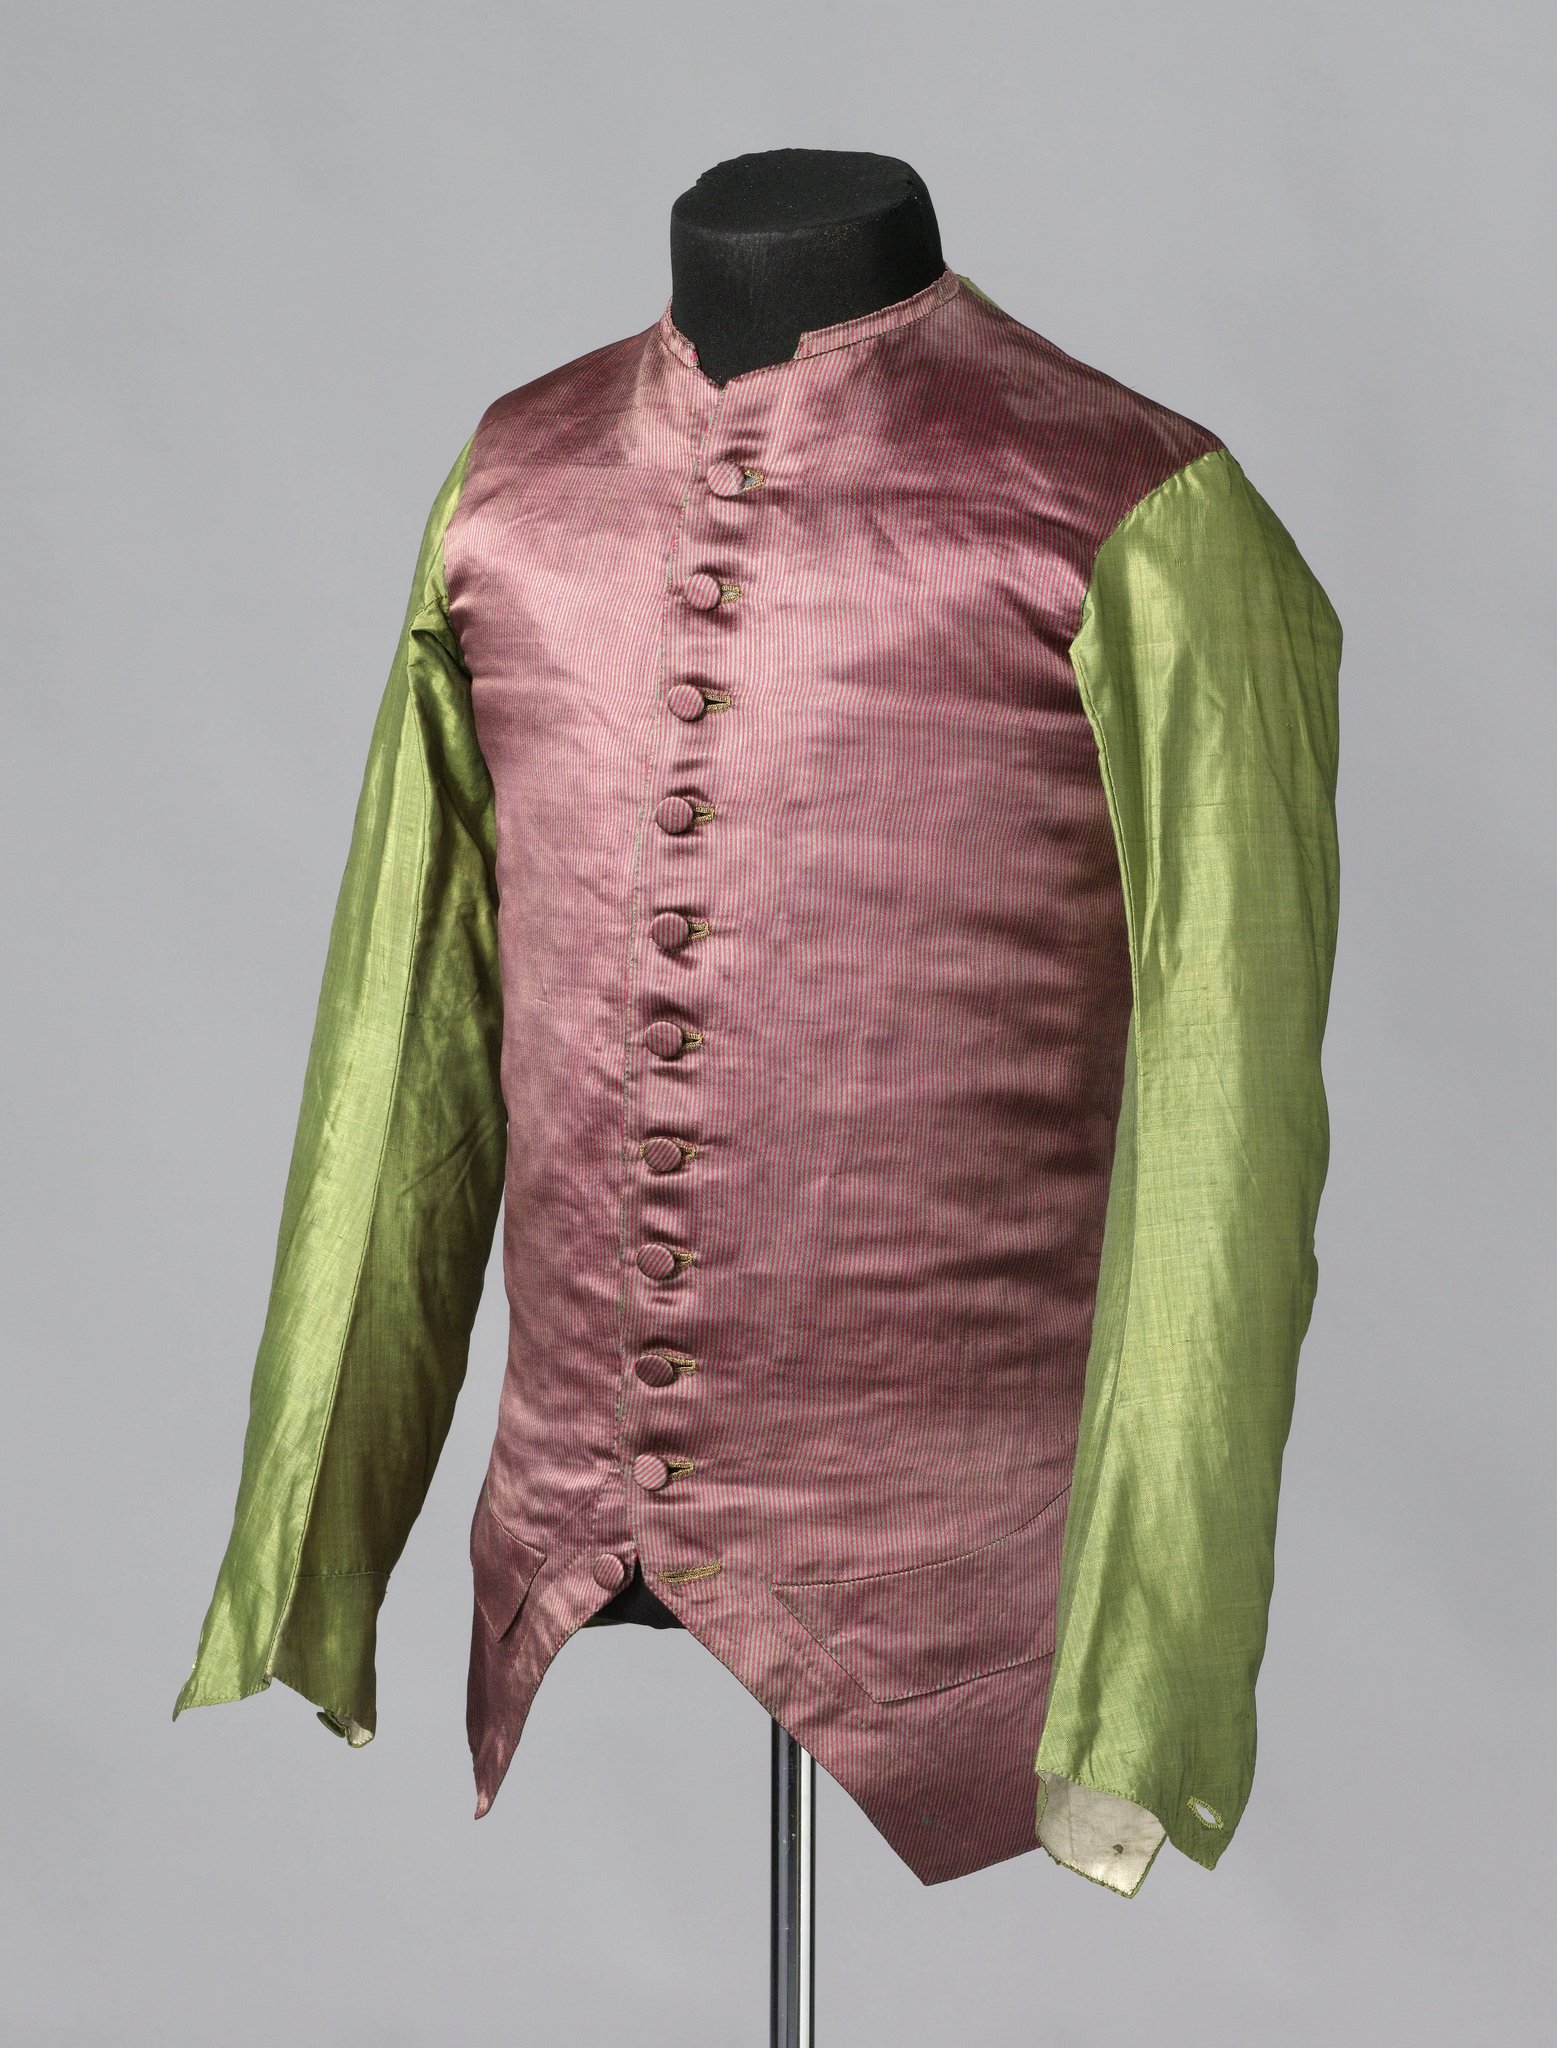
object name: cardigan waistcoat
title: Hooggesloten mouwvest met twee lage zakken met klep en 11 stofknopen, fijn roodgroen gestreept satijn; mouwen en deel van de rug van groene zijde, voering linnen en katoen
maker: Anonymous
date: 1760-1770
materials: cotton, textile, linen, silk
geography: netherlands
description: Hooggesloten mouwvest met twee lage zakken met klep en 11 stofknopen, fijn roodgroen gestreept satijn; mouwen en deel van de rug van groene zijde, voering linnen en katoen. De voering is door Avril Hart (V&A) bestempeld als "fustian" en is half linnen, half katoen.